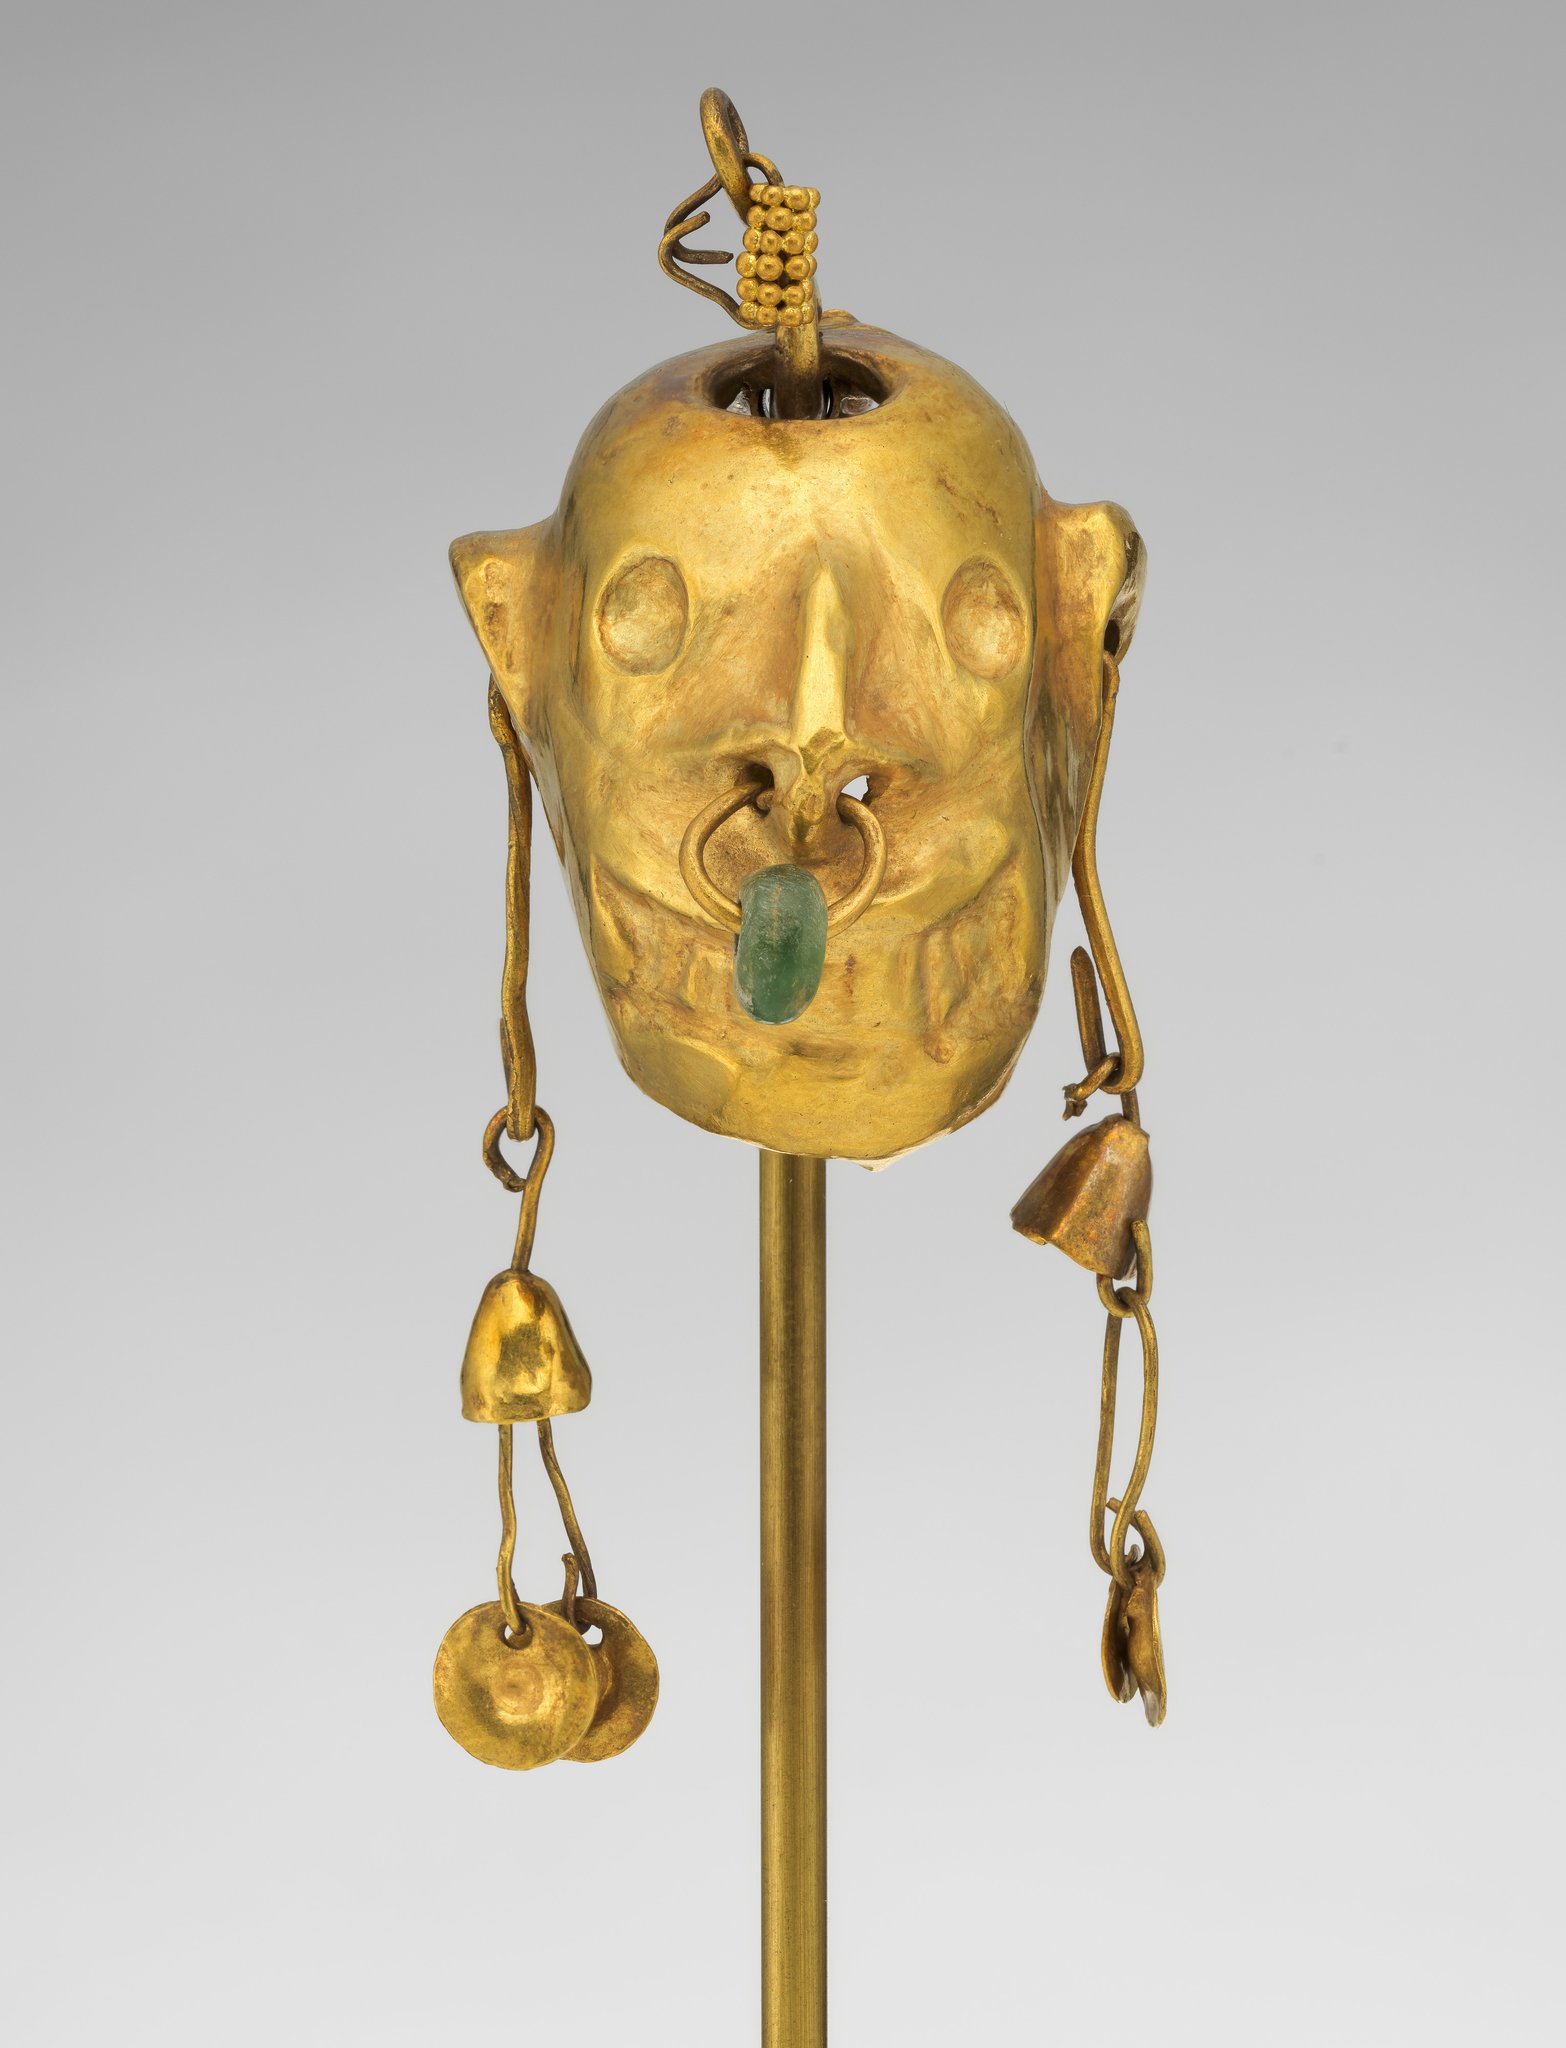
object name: ornament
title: Head shaped ornament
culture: tolita-tumaco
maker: tolita-tumaco artist(s)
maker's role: artist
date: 500 BCE-300 CE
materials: gold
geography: colombia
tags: heads